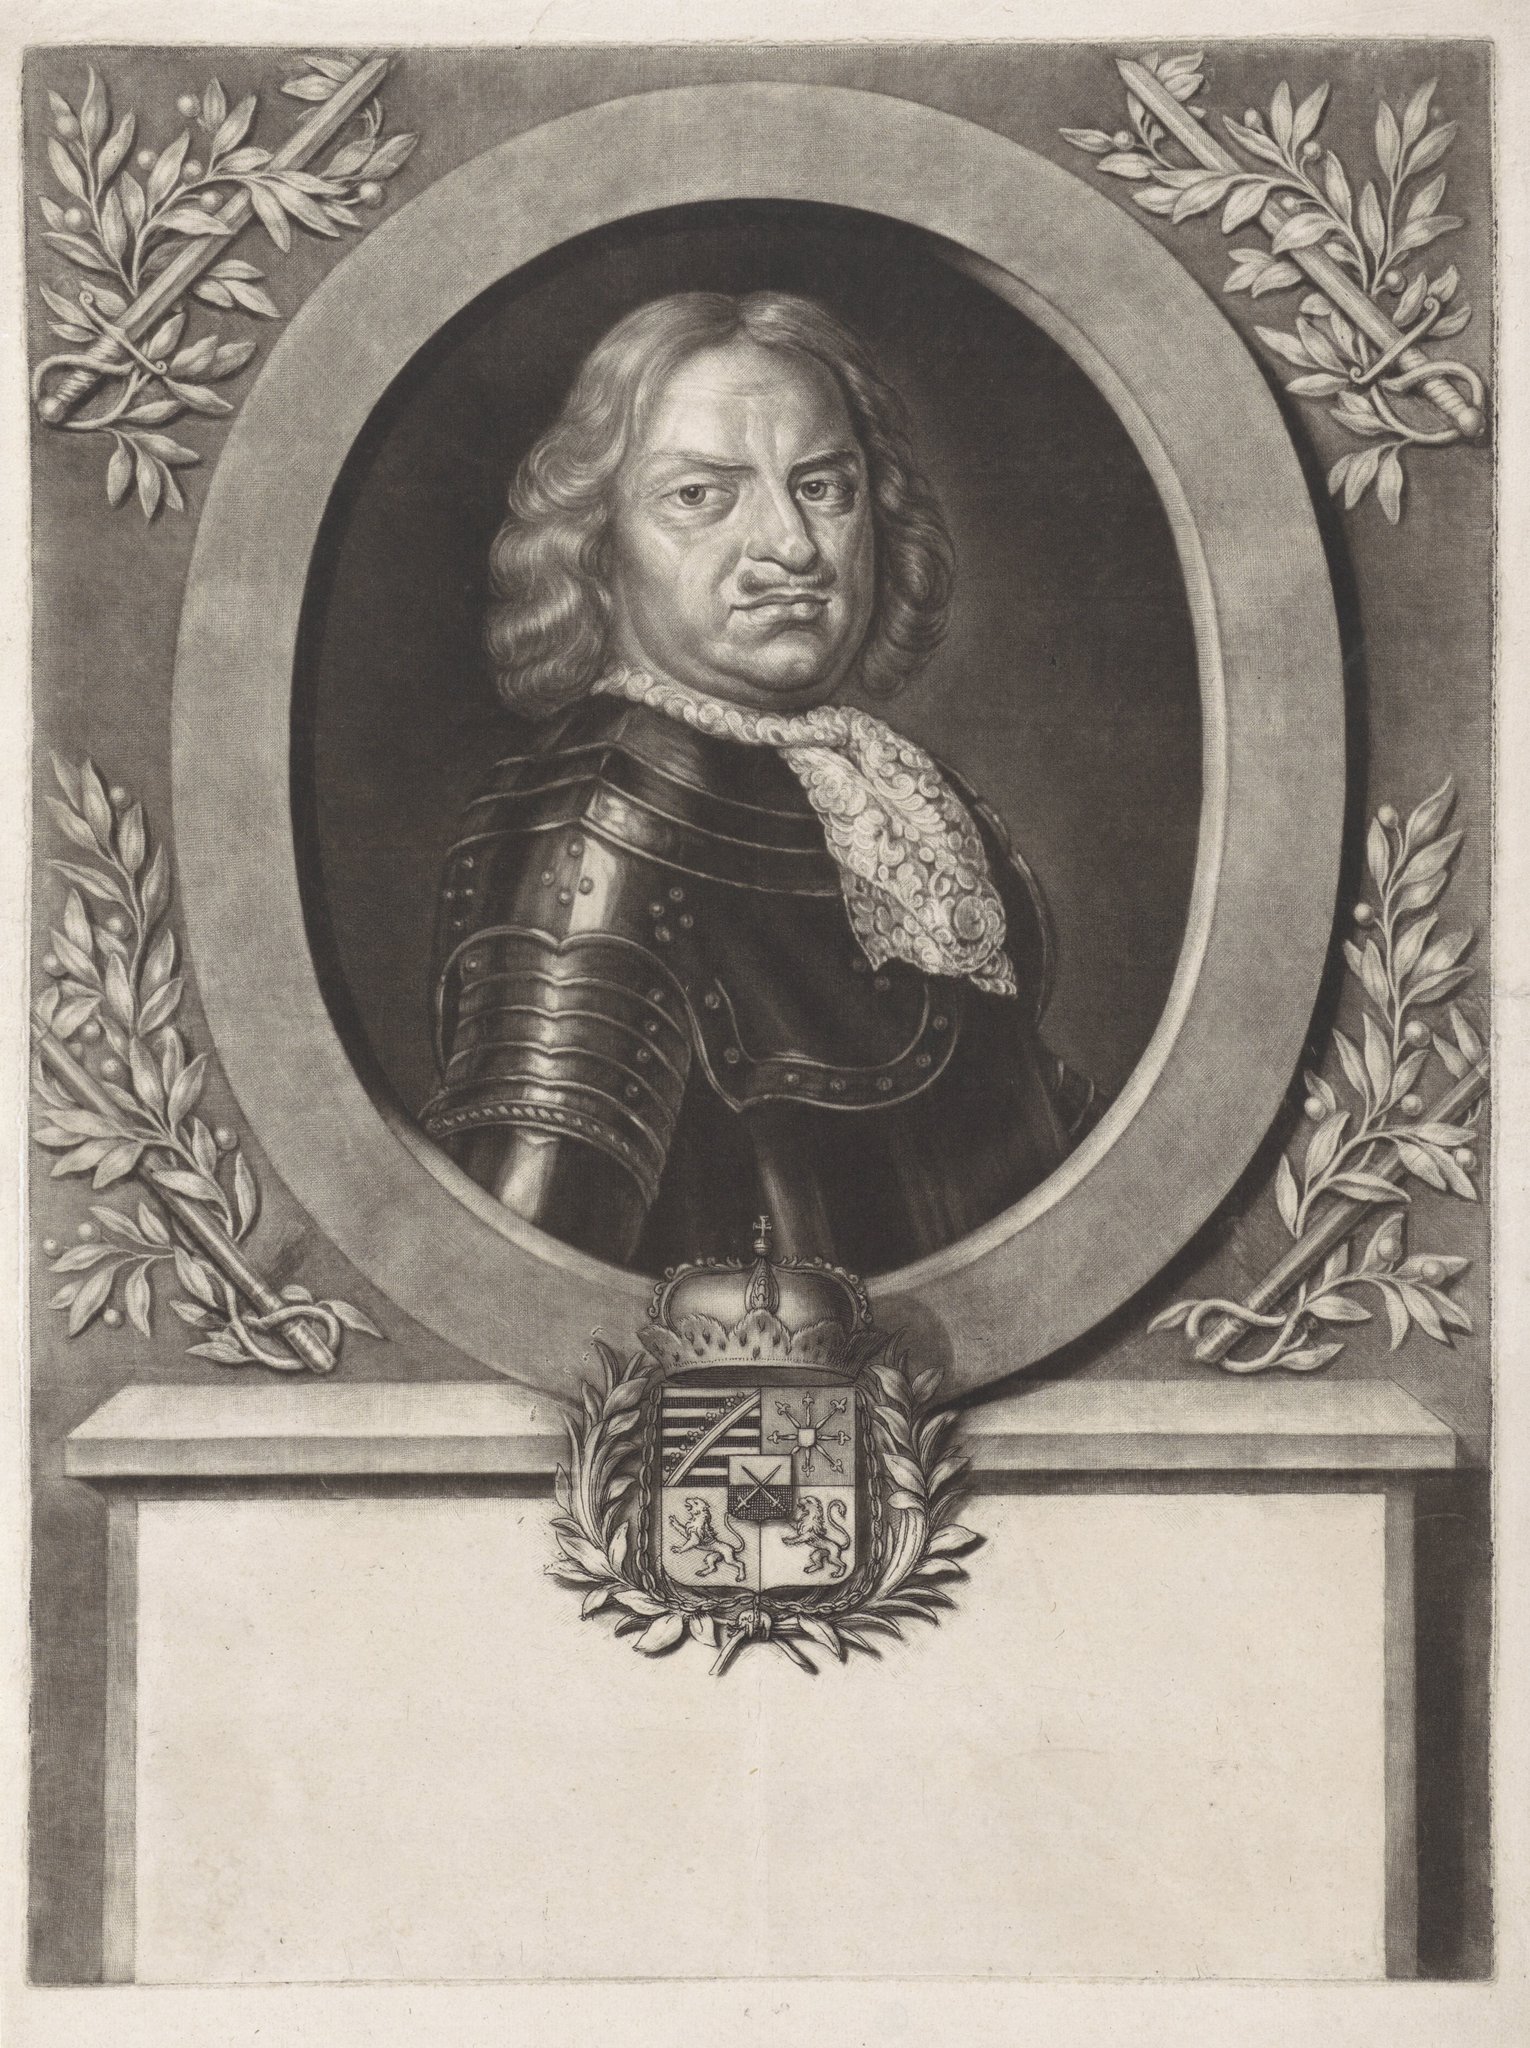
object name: print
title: Portret van Johan Georg II, keurvorst van Saksen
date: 1652-1690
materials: paper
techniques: etching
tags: trees: olive-tree (+ plants used symbolically)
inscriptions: collector's mark: Lugt 2760, collector's mark: Lugt 2228, collector's mark: Lugt 151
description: Portret van Johan Georg II, keurvorst van Saksen. Het portret is omringd door twee staffen, twee zwaarden en vier olijftakken.